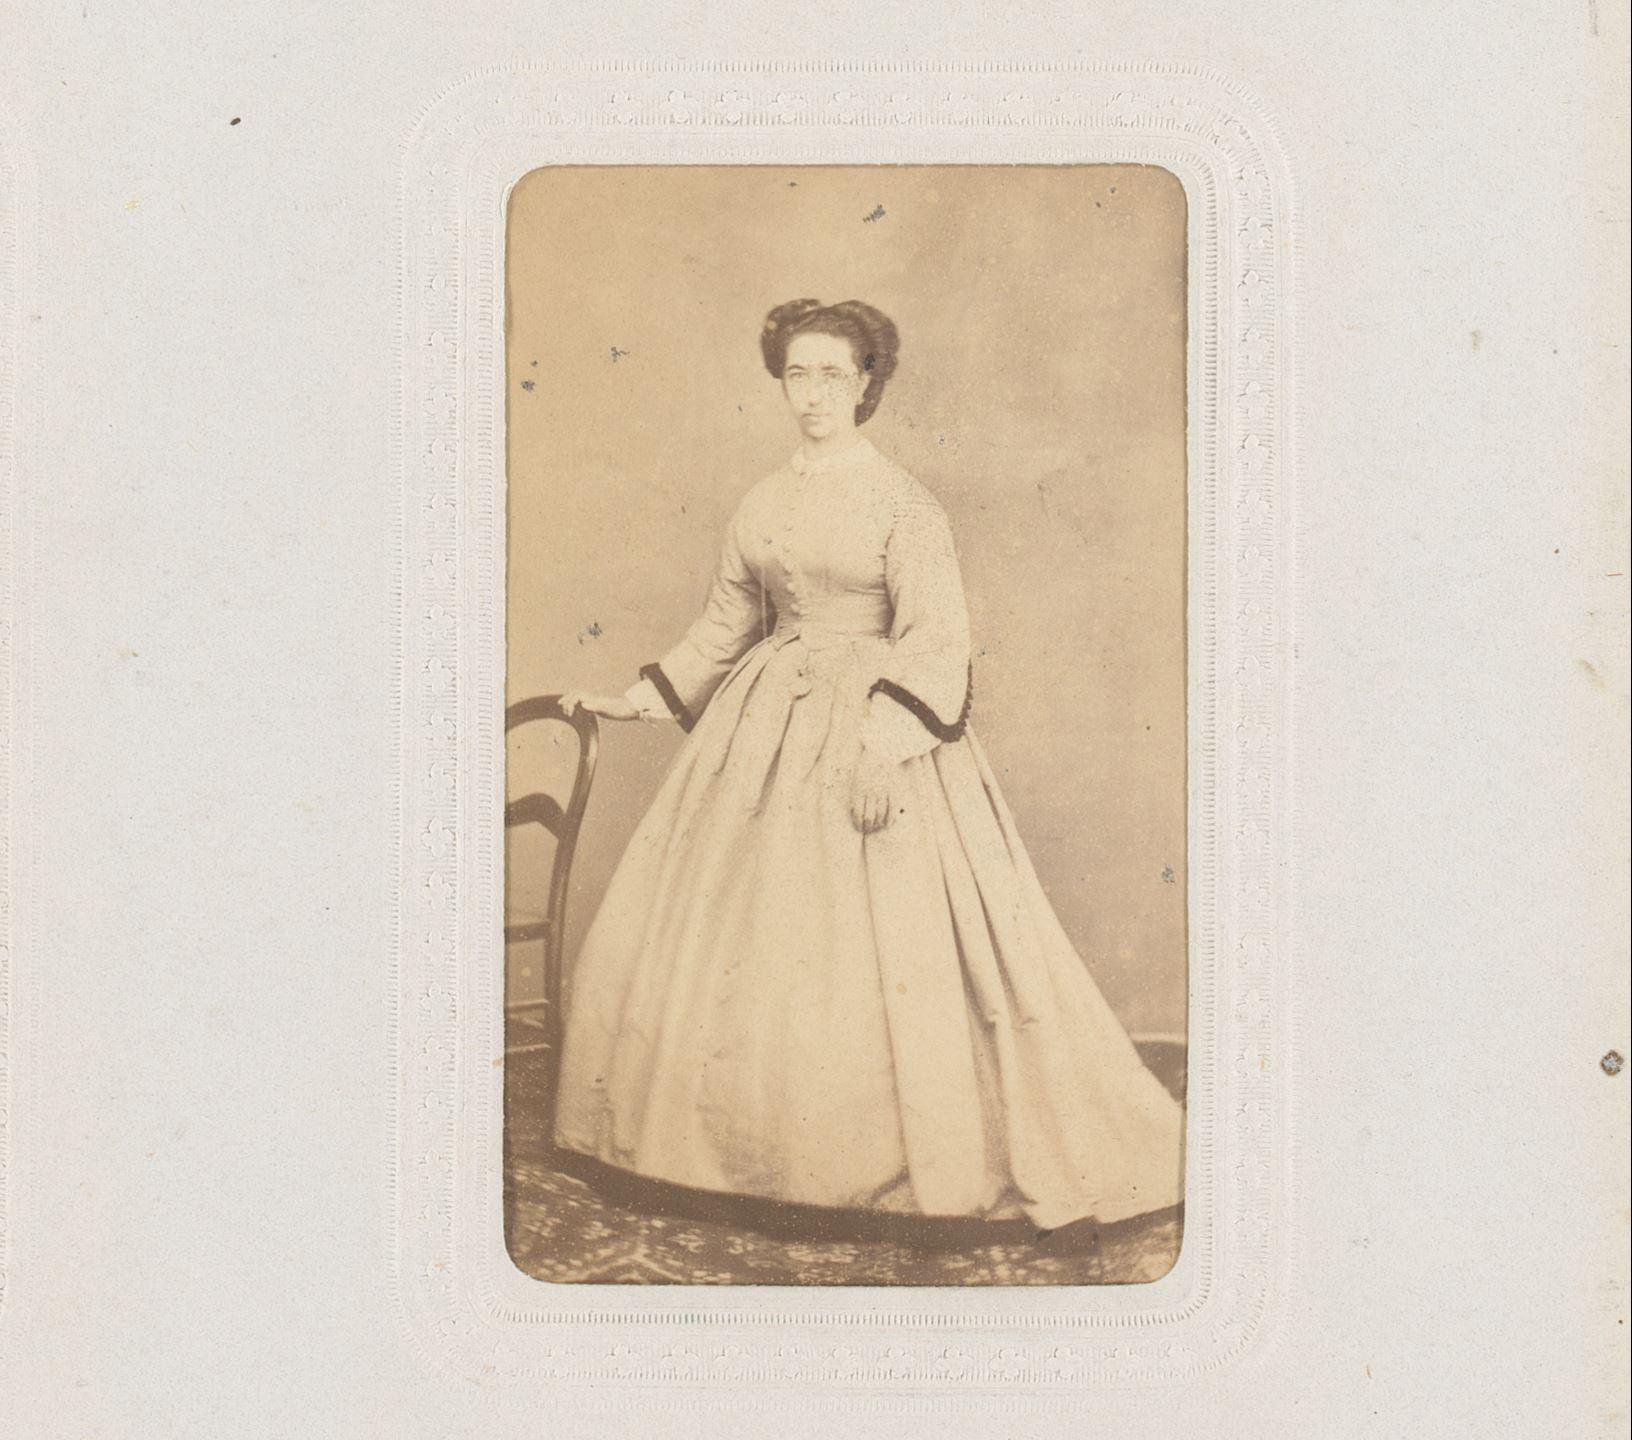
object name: photograph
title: Portret van een vrouw, staand bij een stoel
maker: antonio riudavets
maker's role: fotograaf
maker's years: 1813-1897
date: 1860-1890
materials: cardboard, photographic support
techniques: albumen print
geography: orihuela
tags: historical persons - bb - woman, standing figure - aa - female human figure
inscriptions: inscription: ‘Riudavets/ Pintor/ Esculor y Fotografo/ Orihuela’